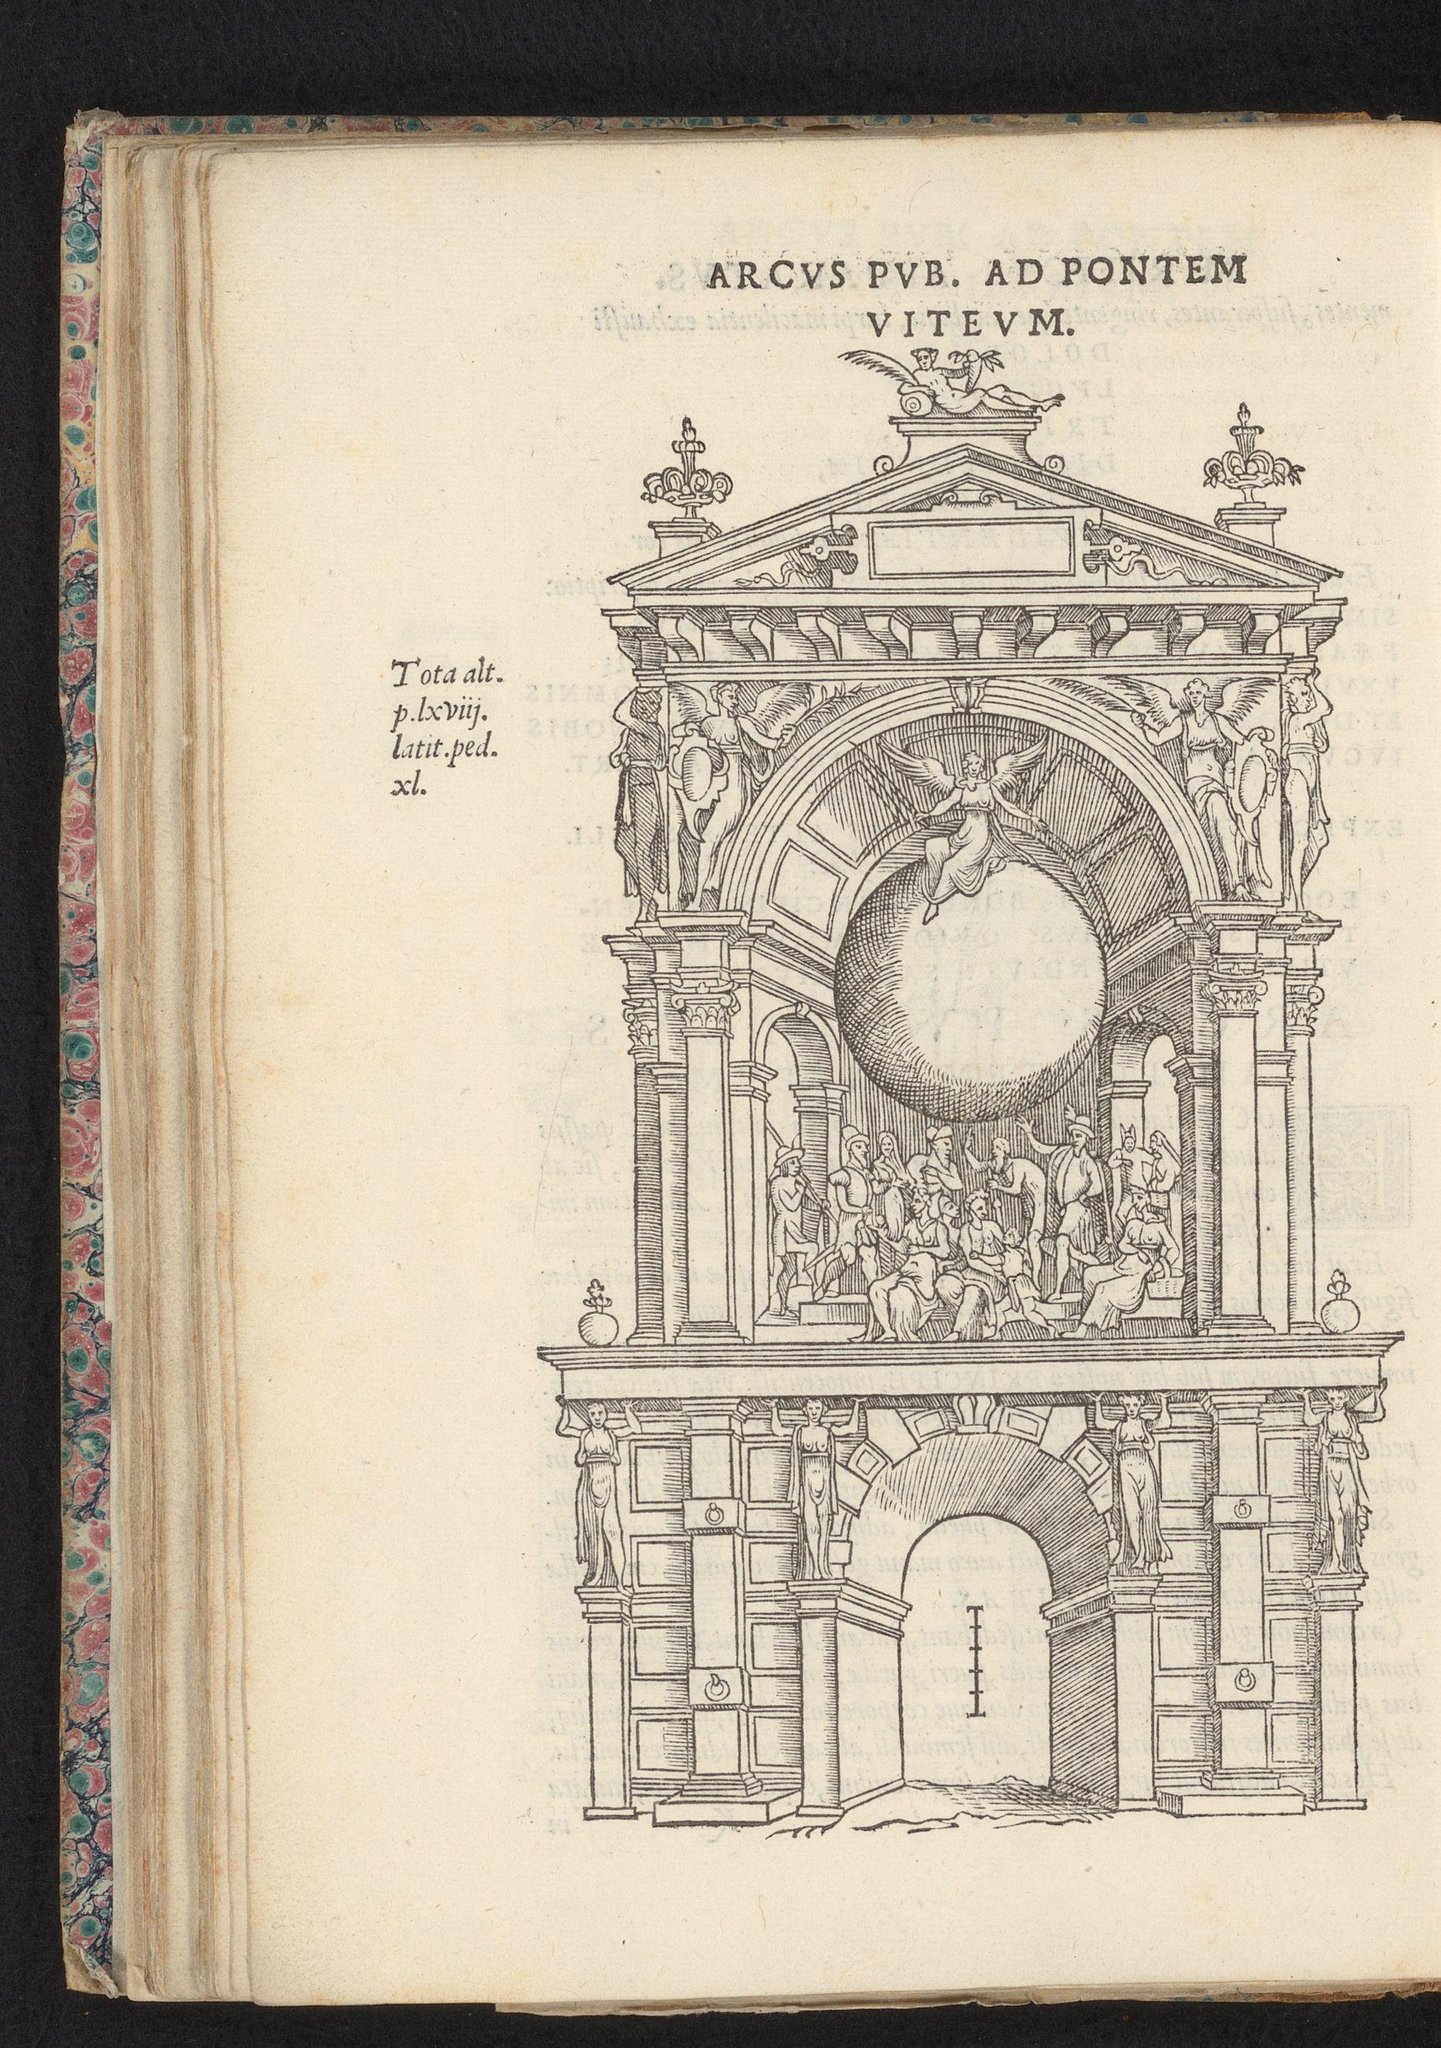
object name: print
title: Arcus pub. ad pontem viteum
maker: pieter coecke van aelst (i)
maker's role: draughtsman, print maker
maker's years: 1502-1550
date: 1549-1550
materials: paper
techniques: woodcut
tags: philip ii of spain, 'tableau vivant', triumphal arch, antwerp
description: Illustratie in: Spectaculorum in susceptione Philippi Hisp. Prin. Divi Caroli. V. Caes. F. ann 1549 Antverpiae aeditorum, mirificus apparatus. Tekst van Cornelius Grapheus, opgedragen aan Filips II, uitgegeven met keizerlijke privilege door Pieter Coecke van Aelst, gedrukt door Gillis van Diest. Boek in de bibliotheek met signatuur: 325 B 13.